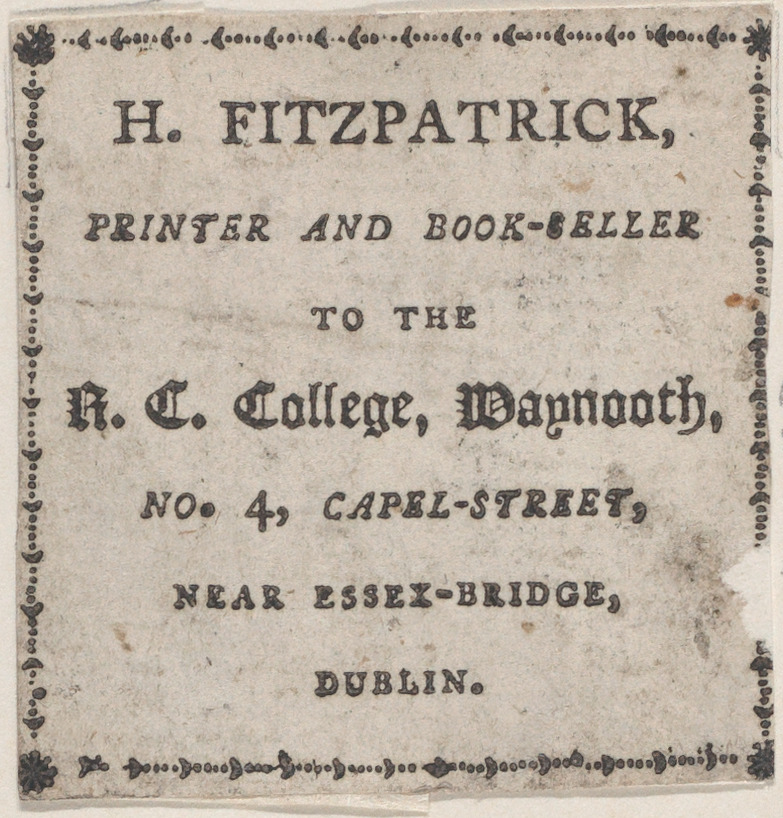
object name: print, trade card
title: Trade Card for H. Fitzpatrick, Printer and Bookseller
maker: anonymous, british, 19th century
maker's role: artist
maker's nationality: british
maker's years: 1800-1900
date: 1801-1900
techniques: engraving